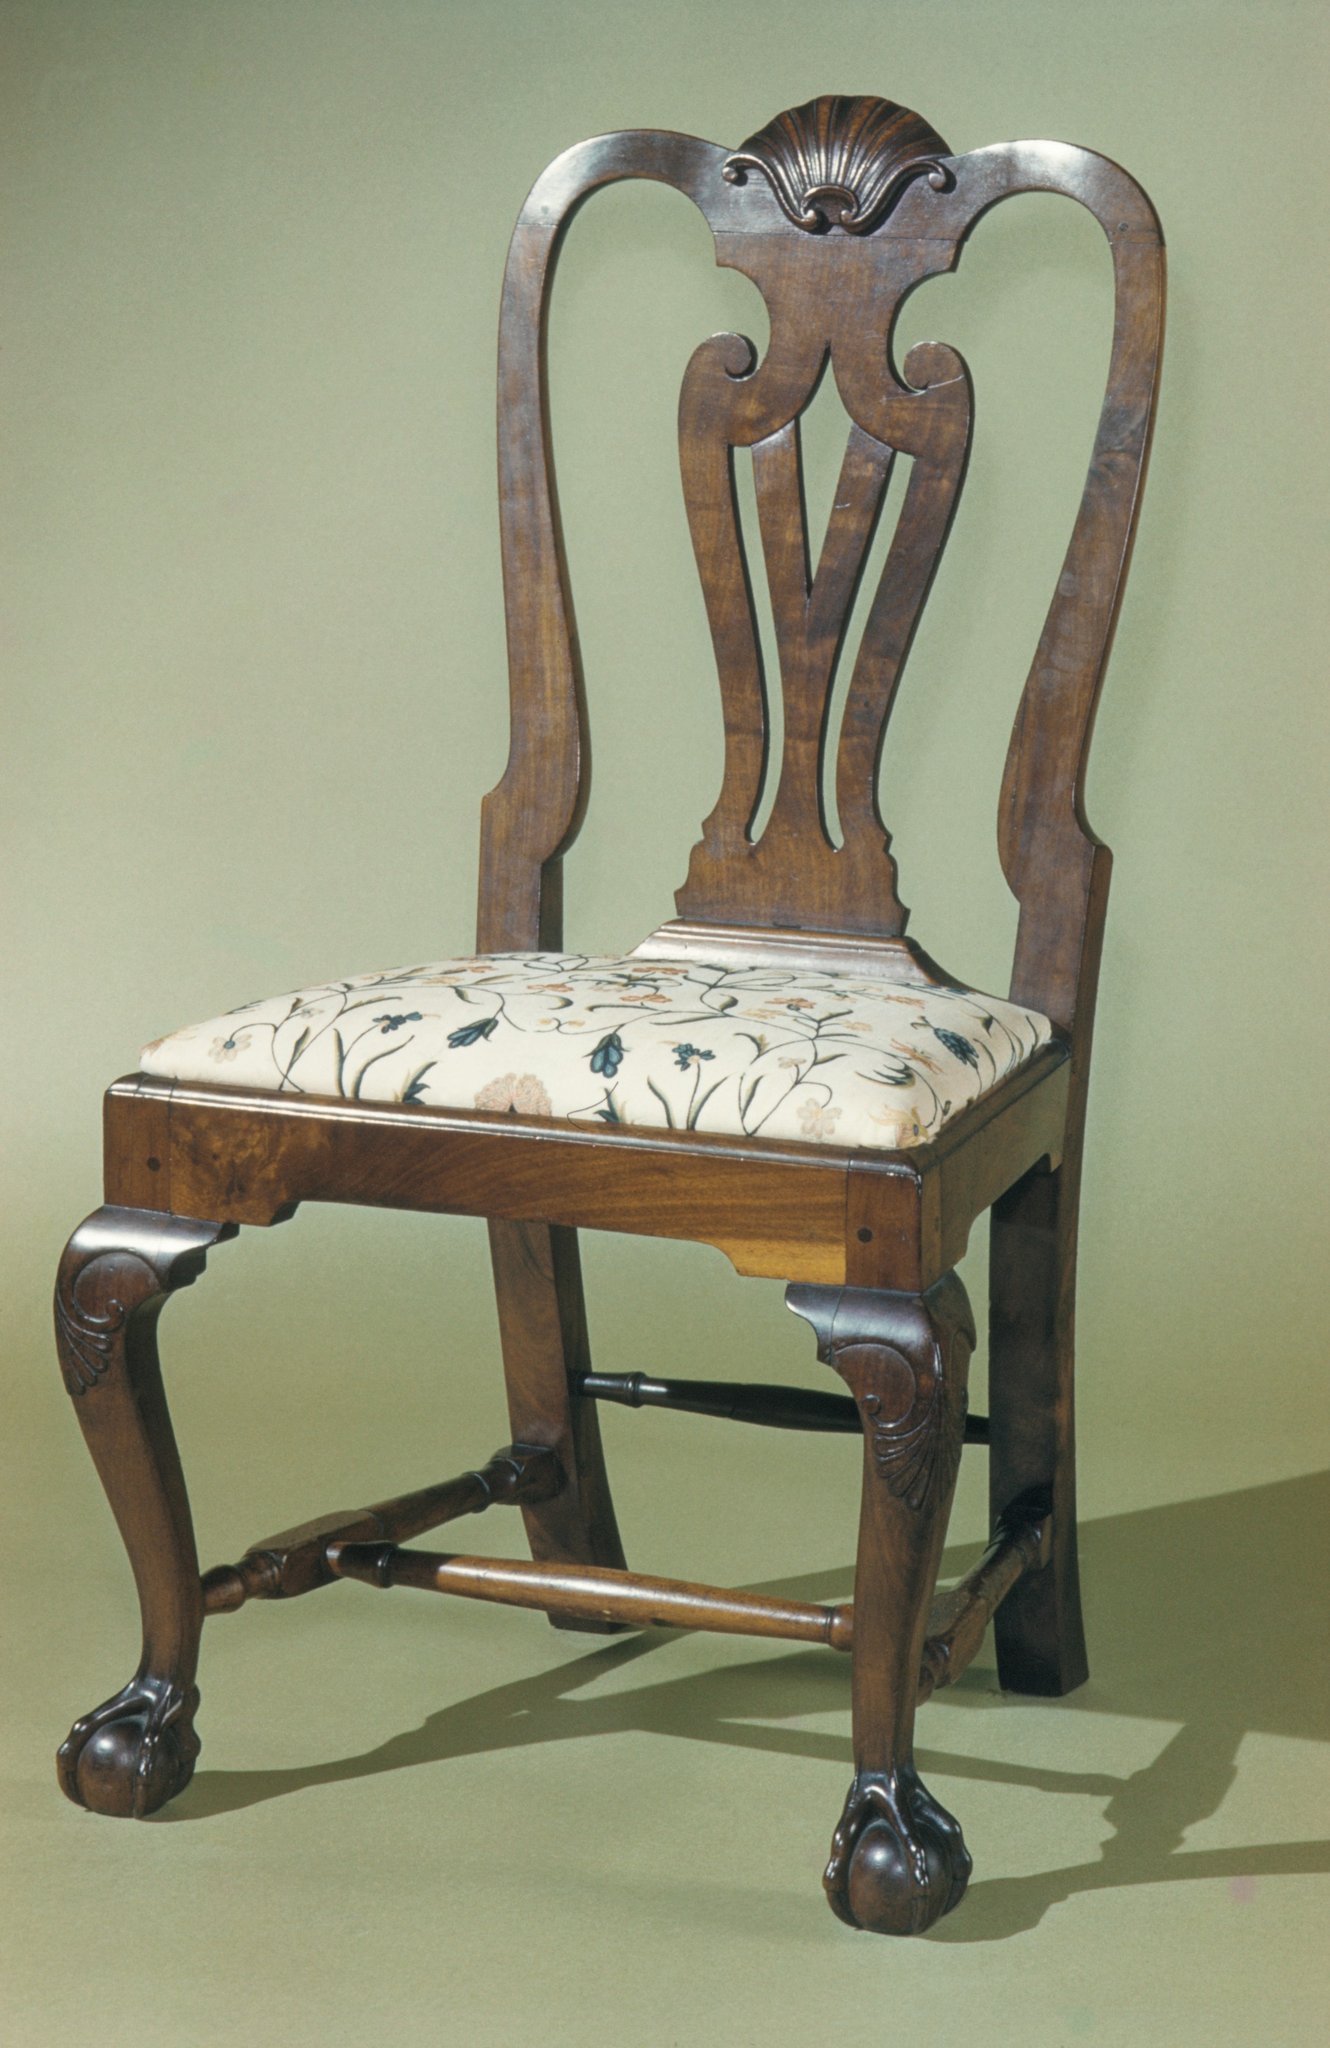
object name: side chair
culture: american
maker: john goddard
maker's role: maker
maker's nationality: american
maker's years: 1723-1785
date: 1760-1785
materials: wood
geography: united states